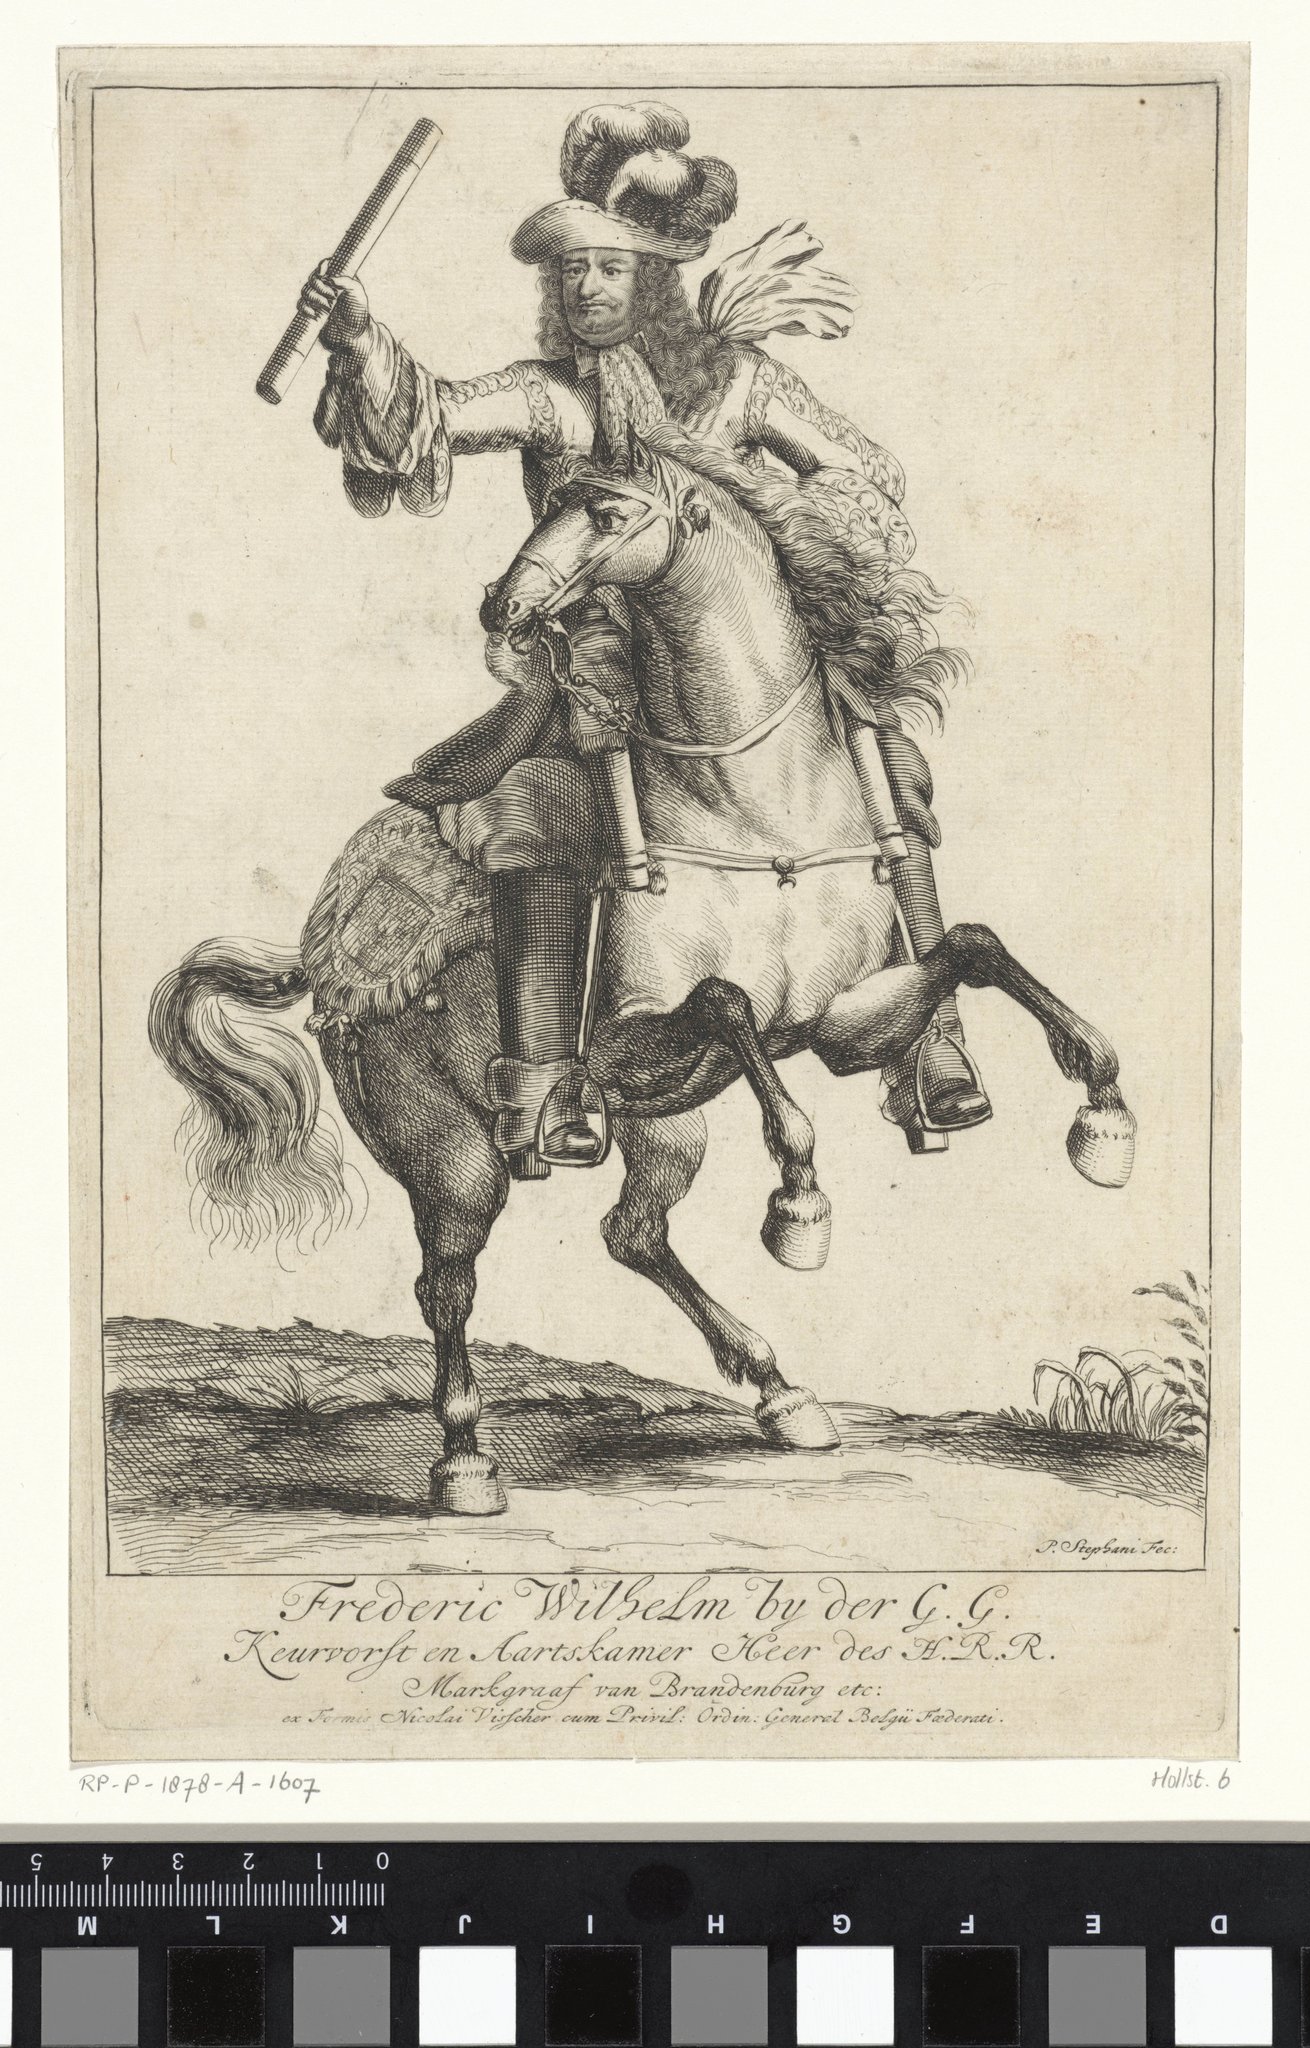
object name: print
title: Ruiterportret van Frederik Willem, keurvorst van Brandenburg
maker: pieter stevens (vermeld in 1689)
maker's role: print maker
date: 1640-1688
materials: paper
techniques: engraving, etching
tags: berlin, frederik willem van brandenburg (i), equestrian state-portrait, baton of general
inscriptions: collector's mark: Lugt 2228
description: Portret van Frederik Willem, keurvorst van Brandenburg, te paard met een commandostaf in zijn hand. Onderaan in de marge zijn naam en functie in het Nederlands.